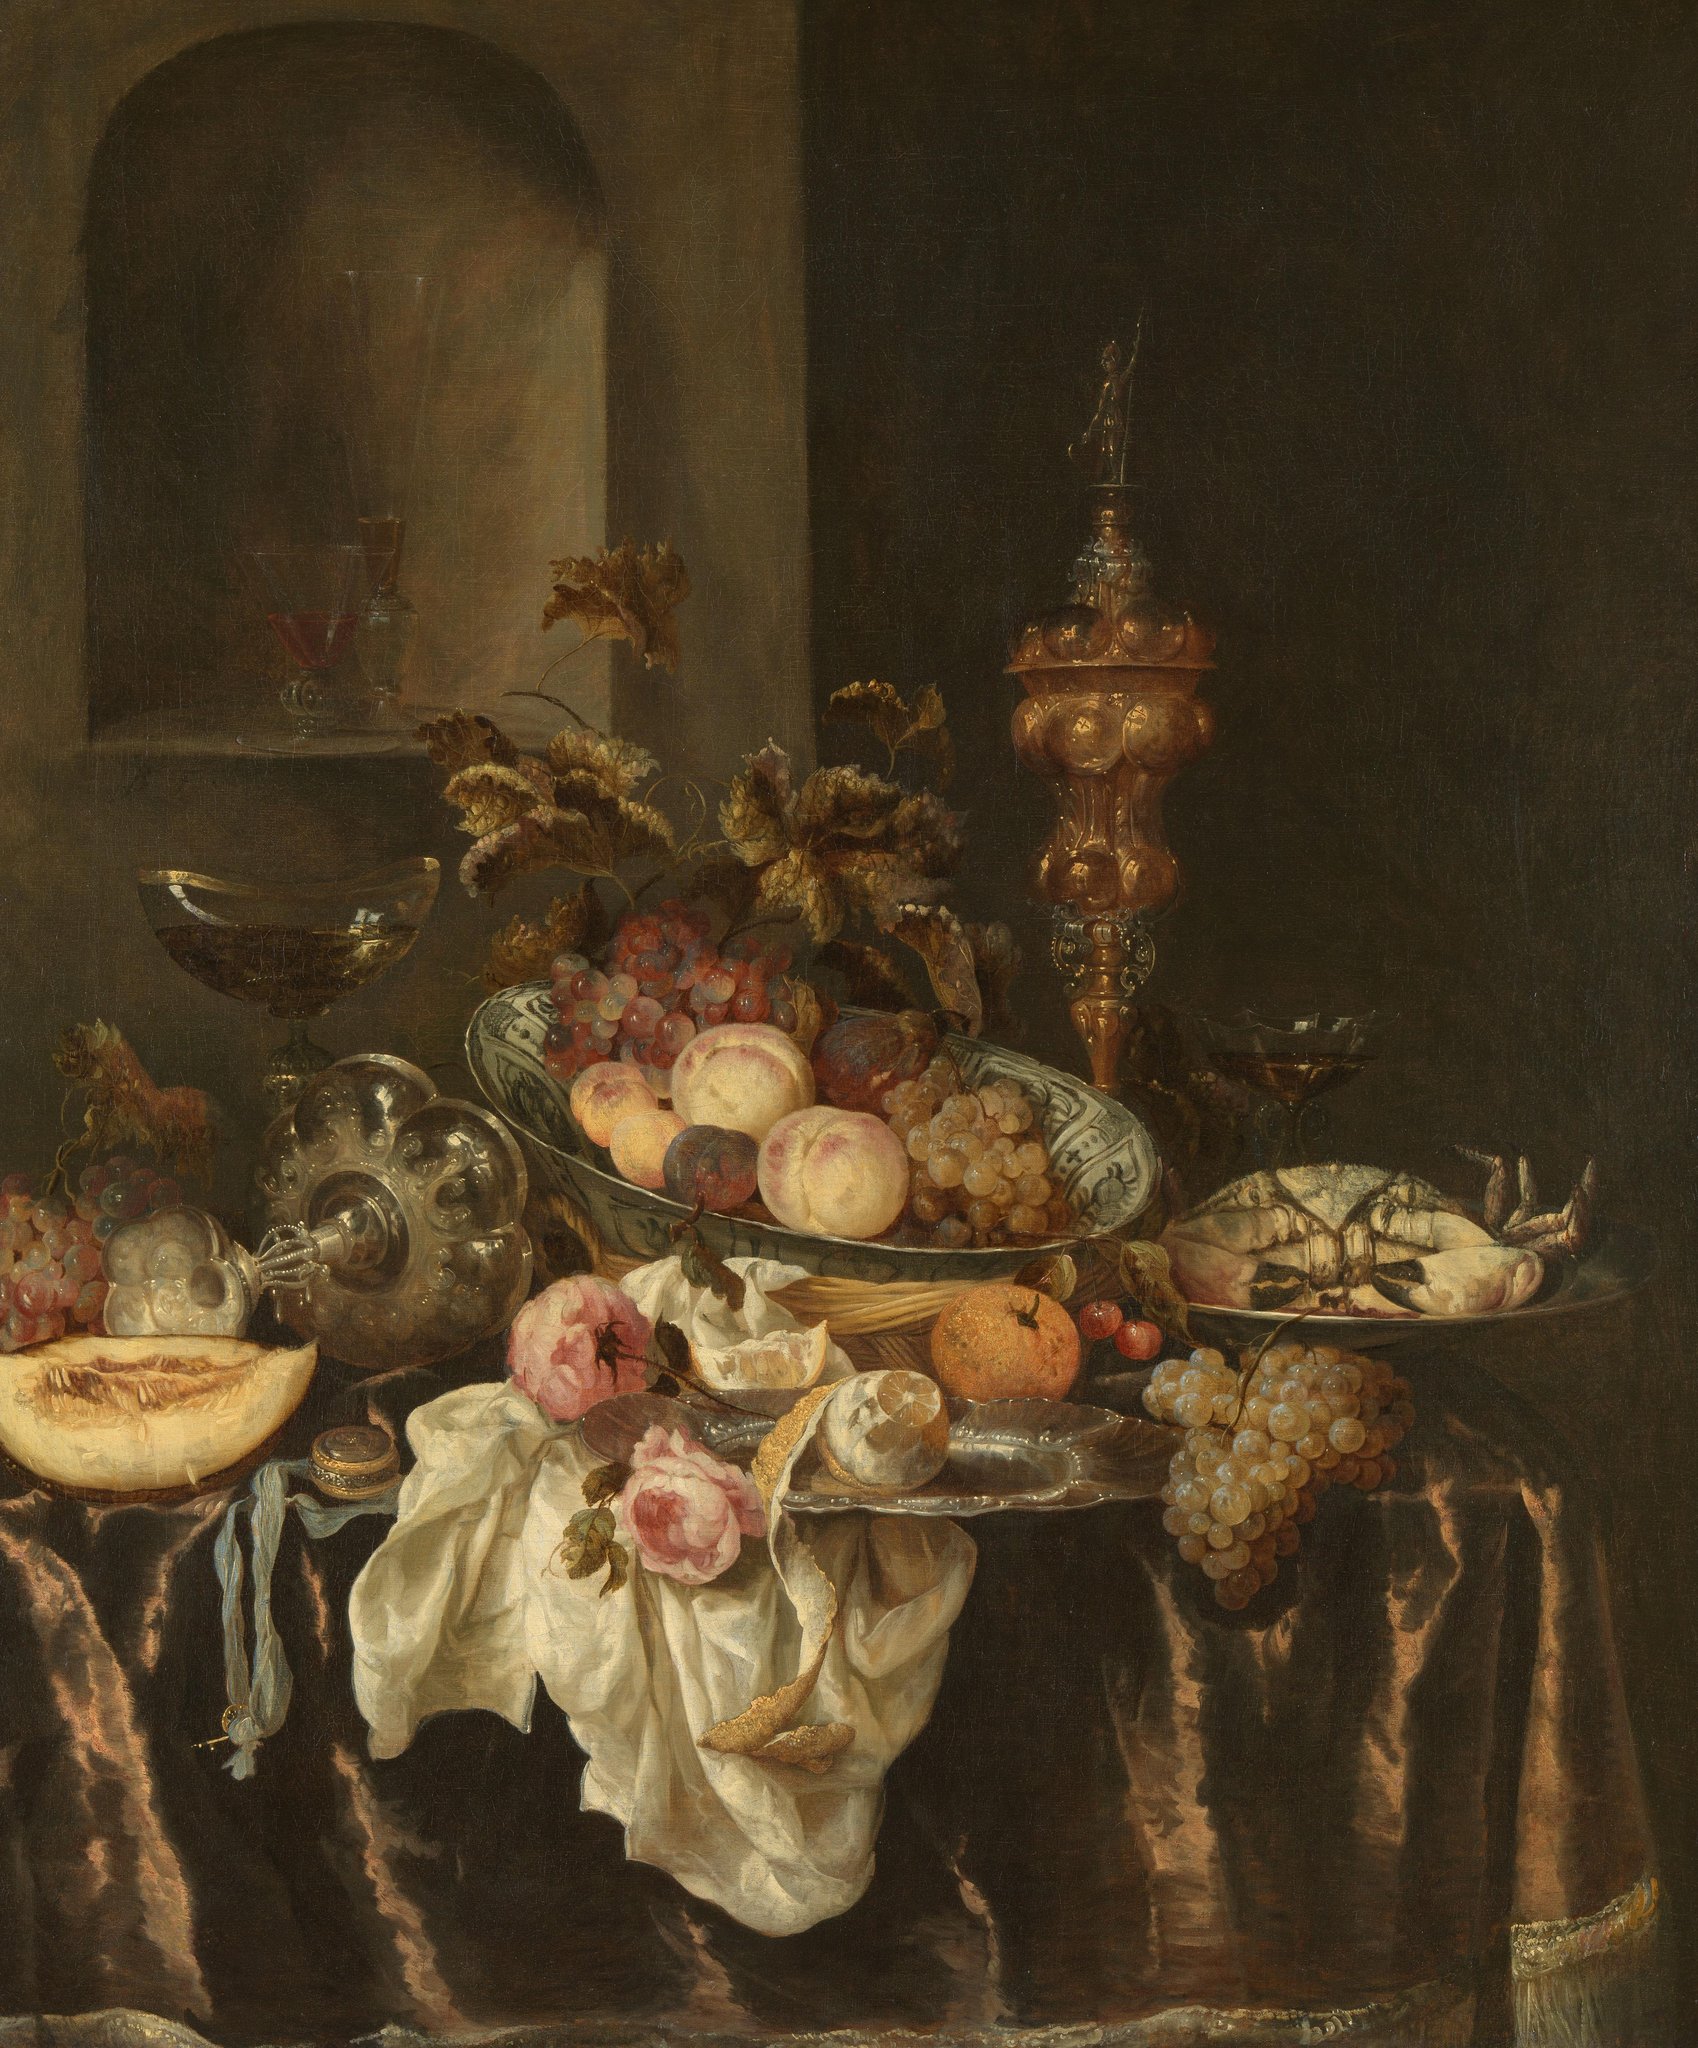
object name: painting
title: Still Life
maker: abraham van beyeren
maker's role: painter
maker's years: 1620-1690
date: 1655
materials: canvas, oil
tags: still life of plants, flowers and fruit, crustaceans: crab, laid table as still life, watch, fruits: lemon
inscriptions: signature, with ligated monogram, upper left, below the niche (false): ‘AVB f.’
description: Abraham van Beyeren (1620/21 - 1690). Still life, c. 1660. The Hague painter Van Beyeren has assembled a colourful assortment of objects and fruits. This type of luxurious still life was in fashion around 1650. Van Beyeren specialized in the genre, following in the footsteps of Jan Davidsz de Heem, who developed this type of still life. Purchased in 1958.